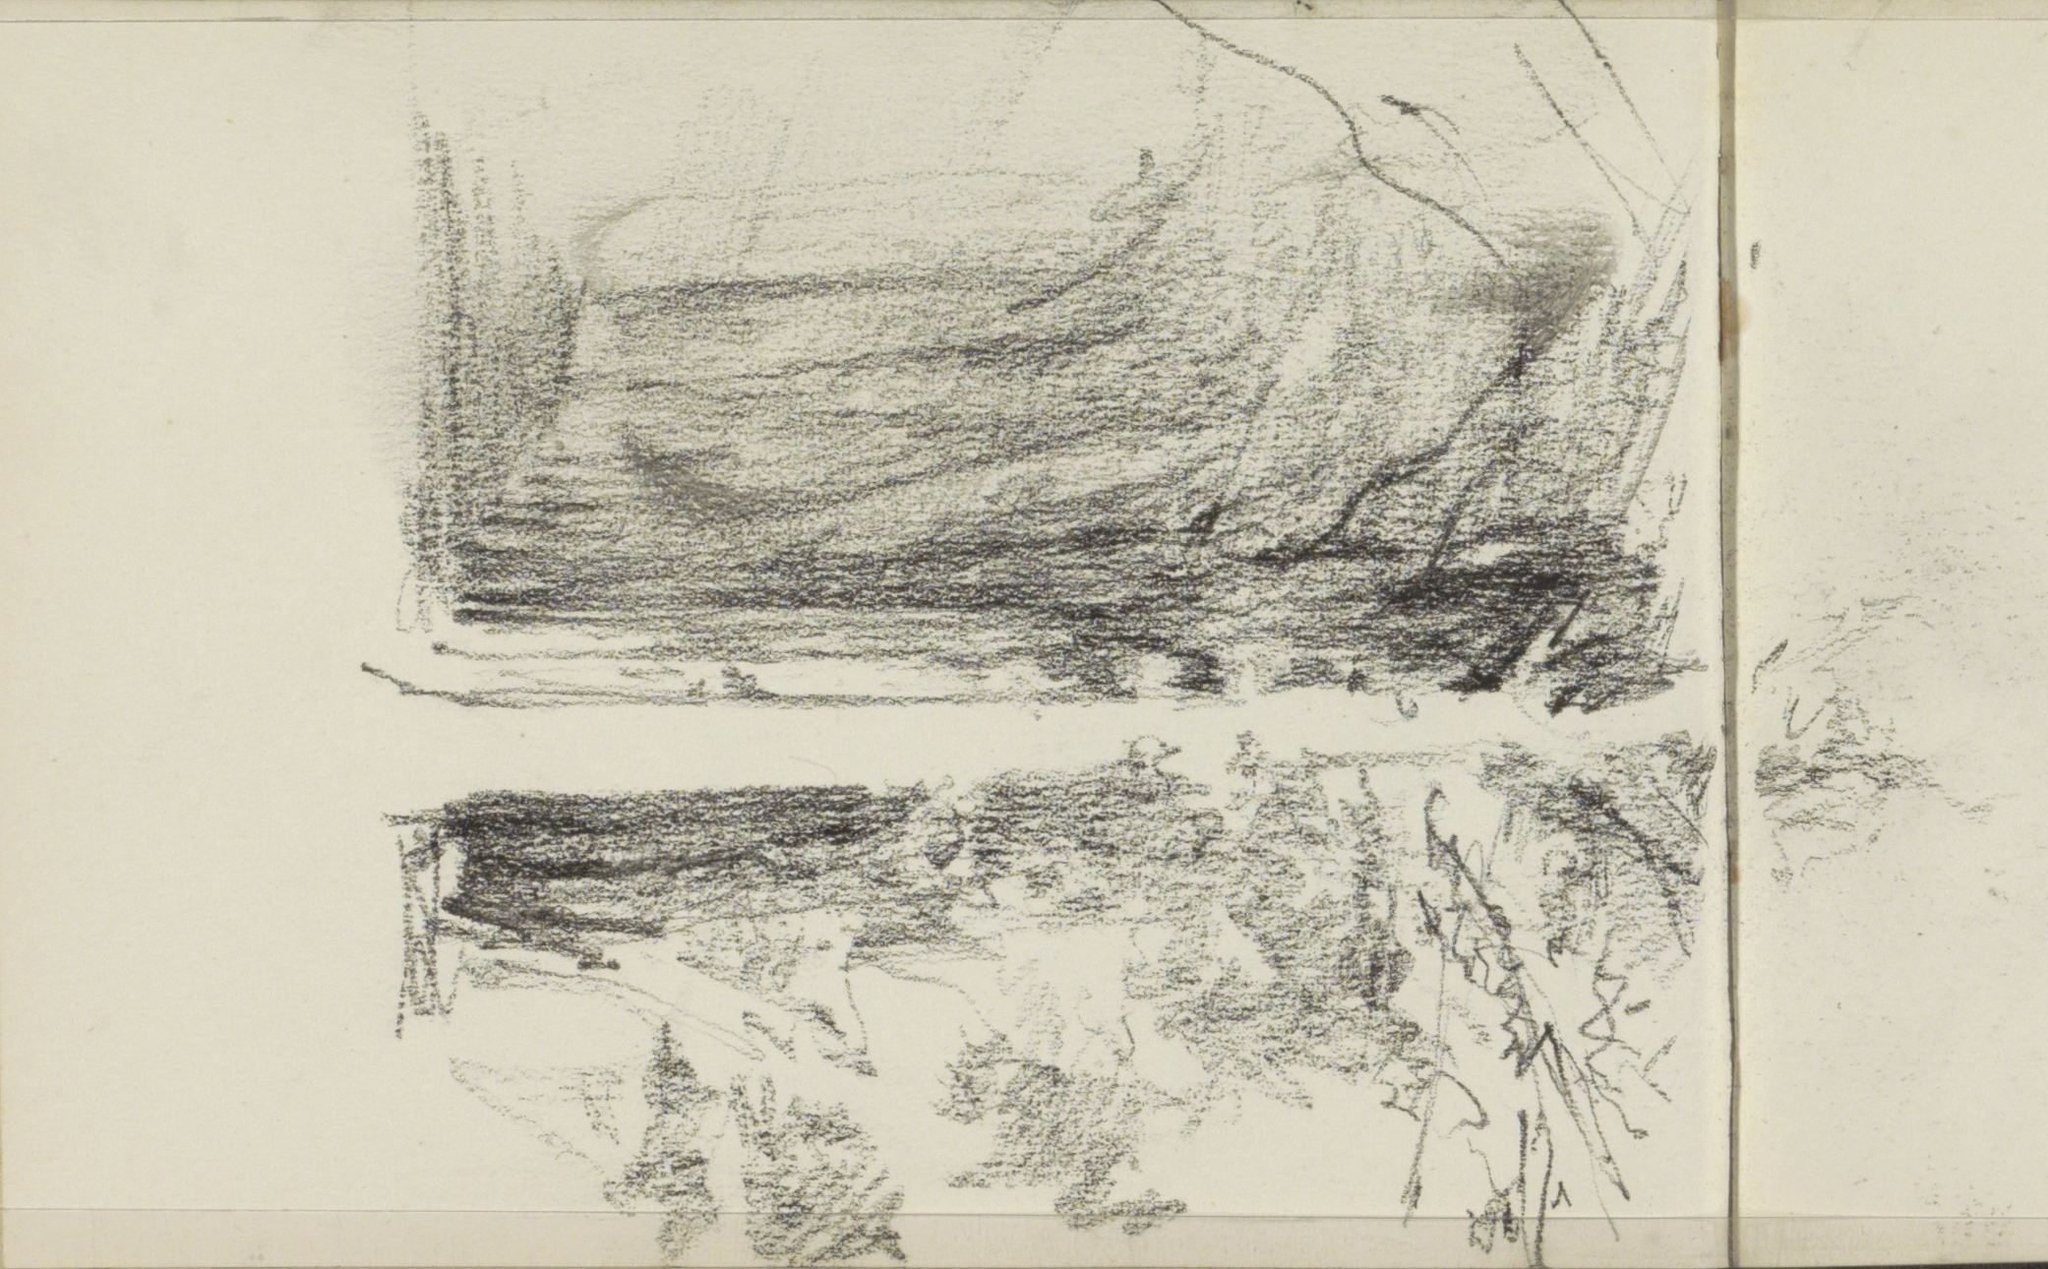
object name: sketchbook leaf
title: Boom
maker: a.a.l. de grammont-hubrecht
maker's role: draughtsman, painter, print maker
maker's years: 1855-1913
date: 1865-1913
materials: chalk, paper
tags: trees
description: Blad 26 verso en 27 recto uit een schetsboek met 38 bladen.